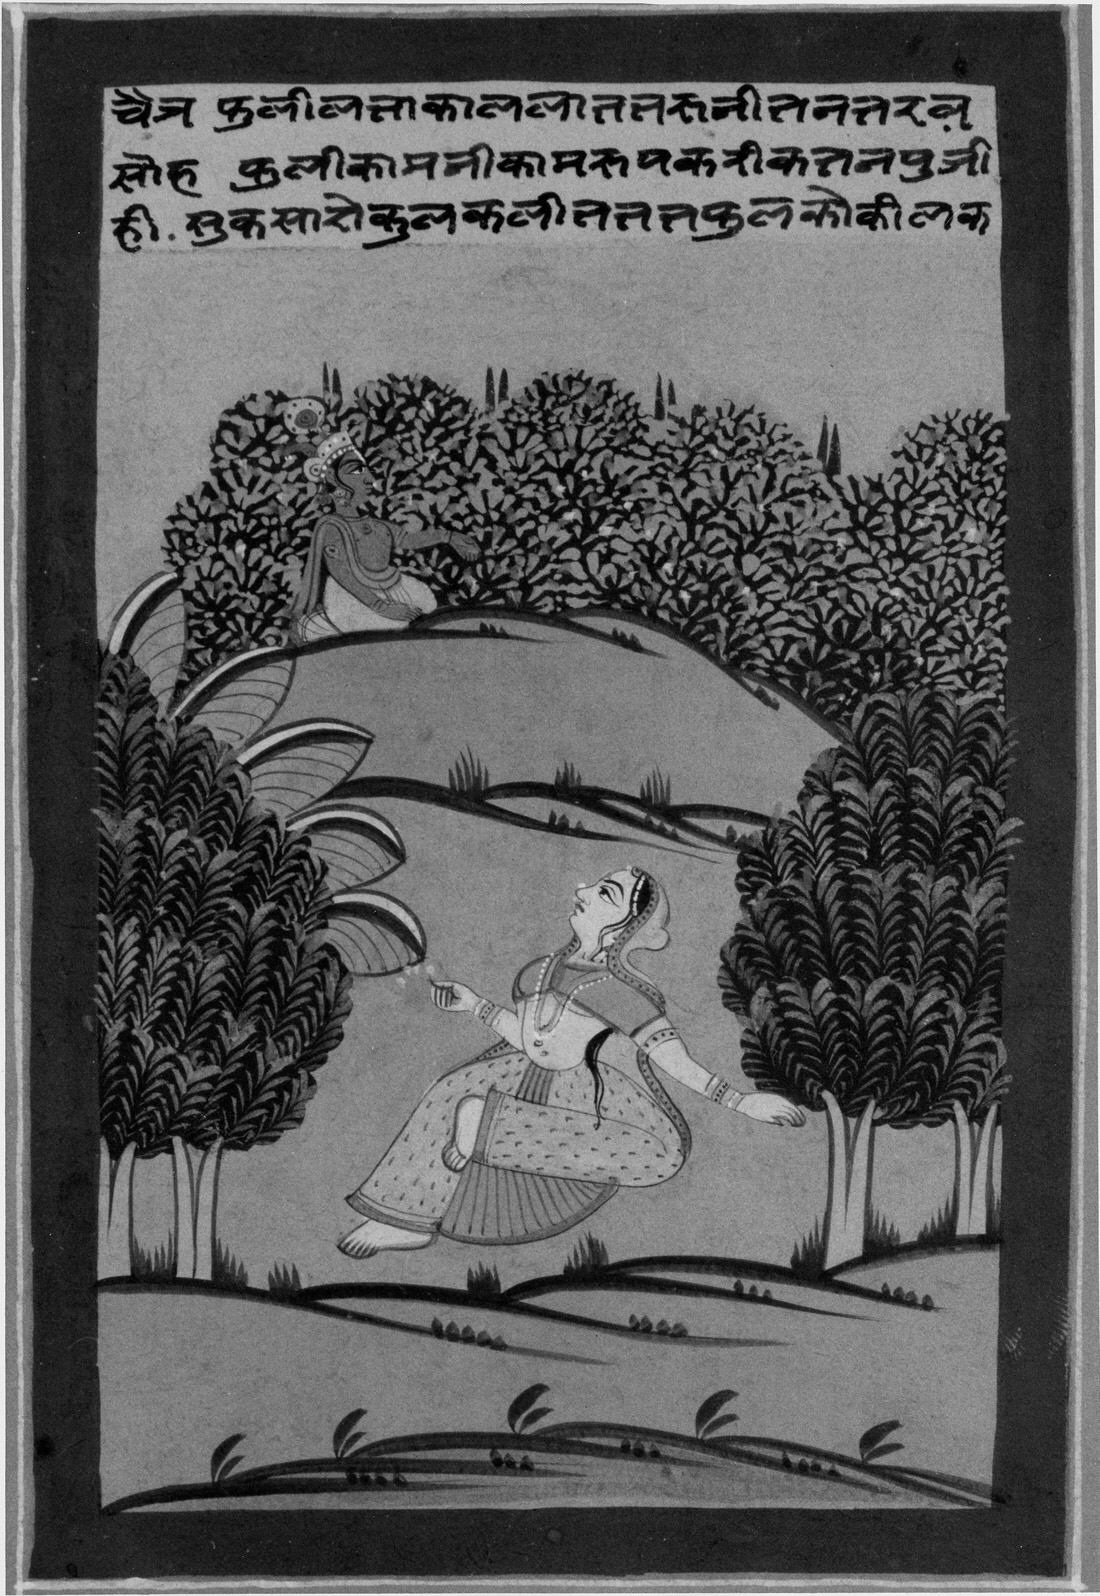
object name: leaf from a ragamala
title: Krishna and Radha in Landscape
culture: indian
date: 1867-1933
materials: gold, paper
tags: krishna,radha